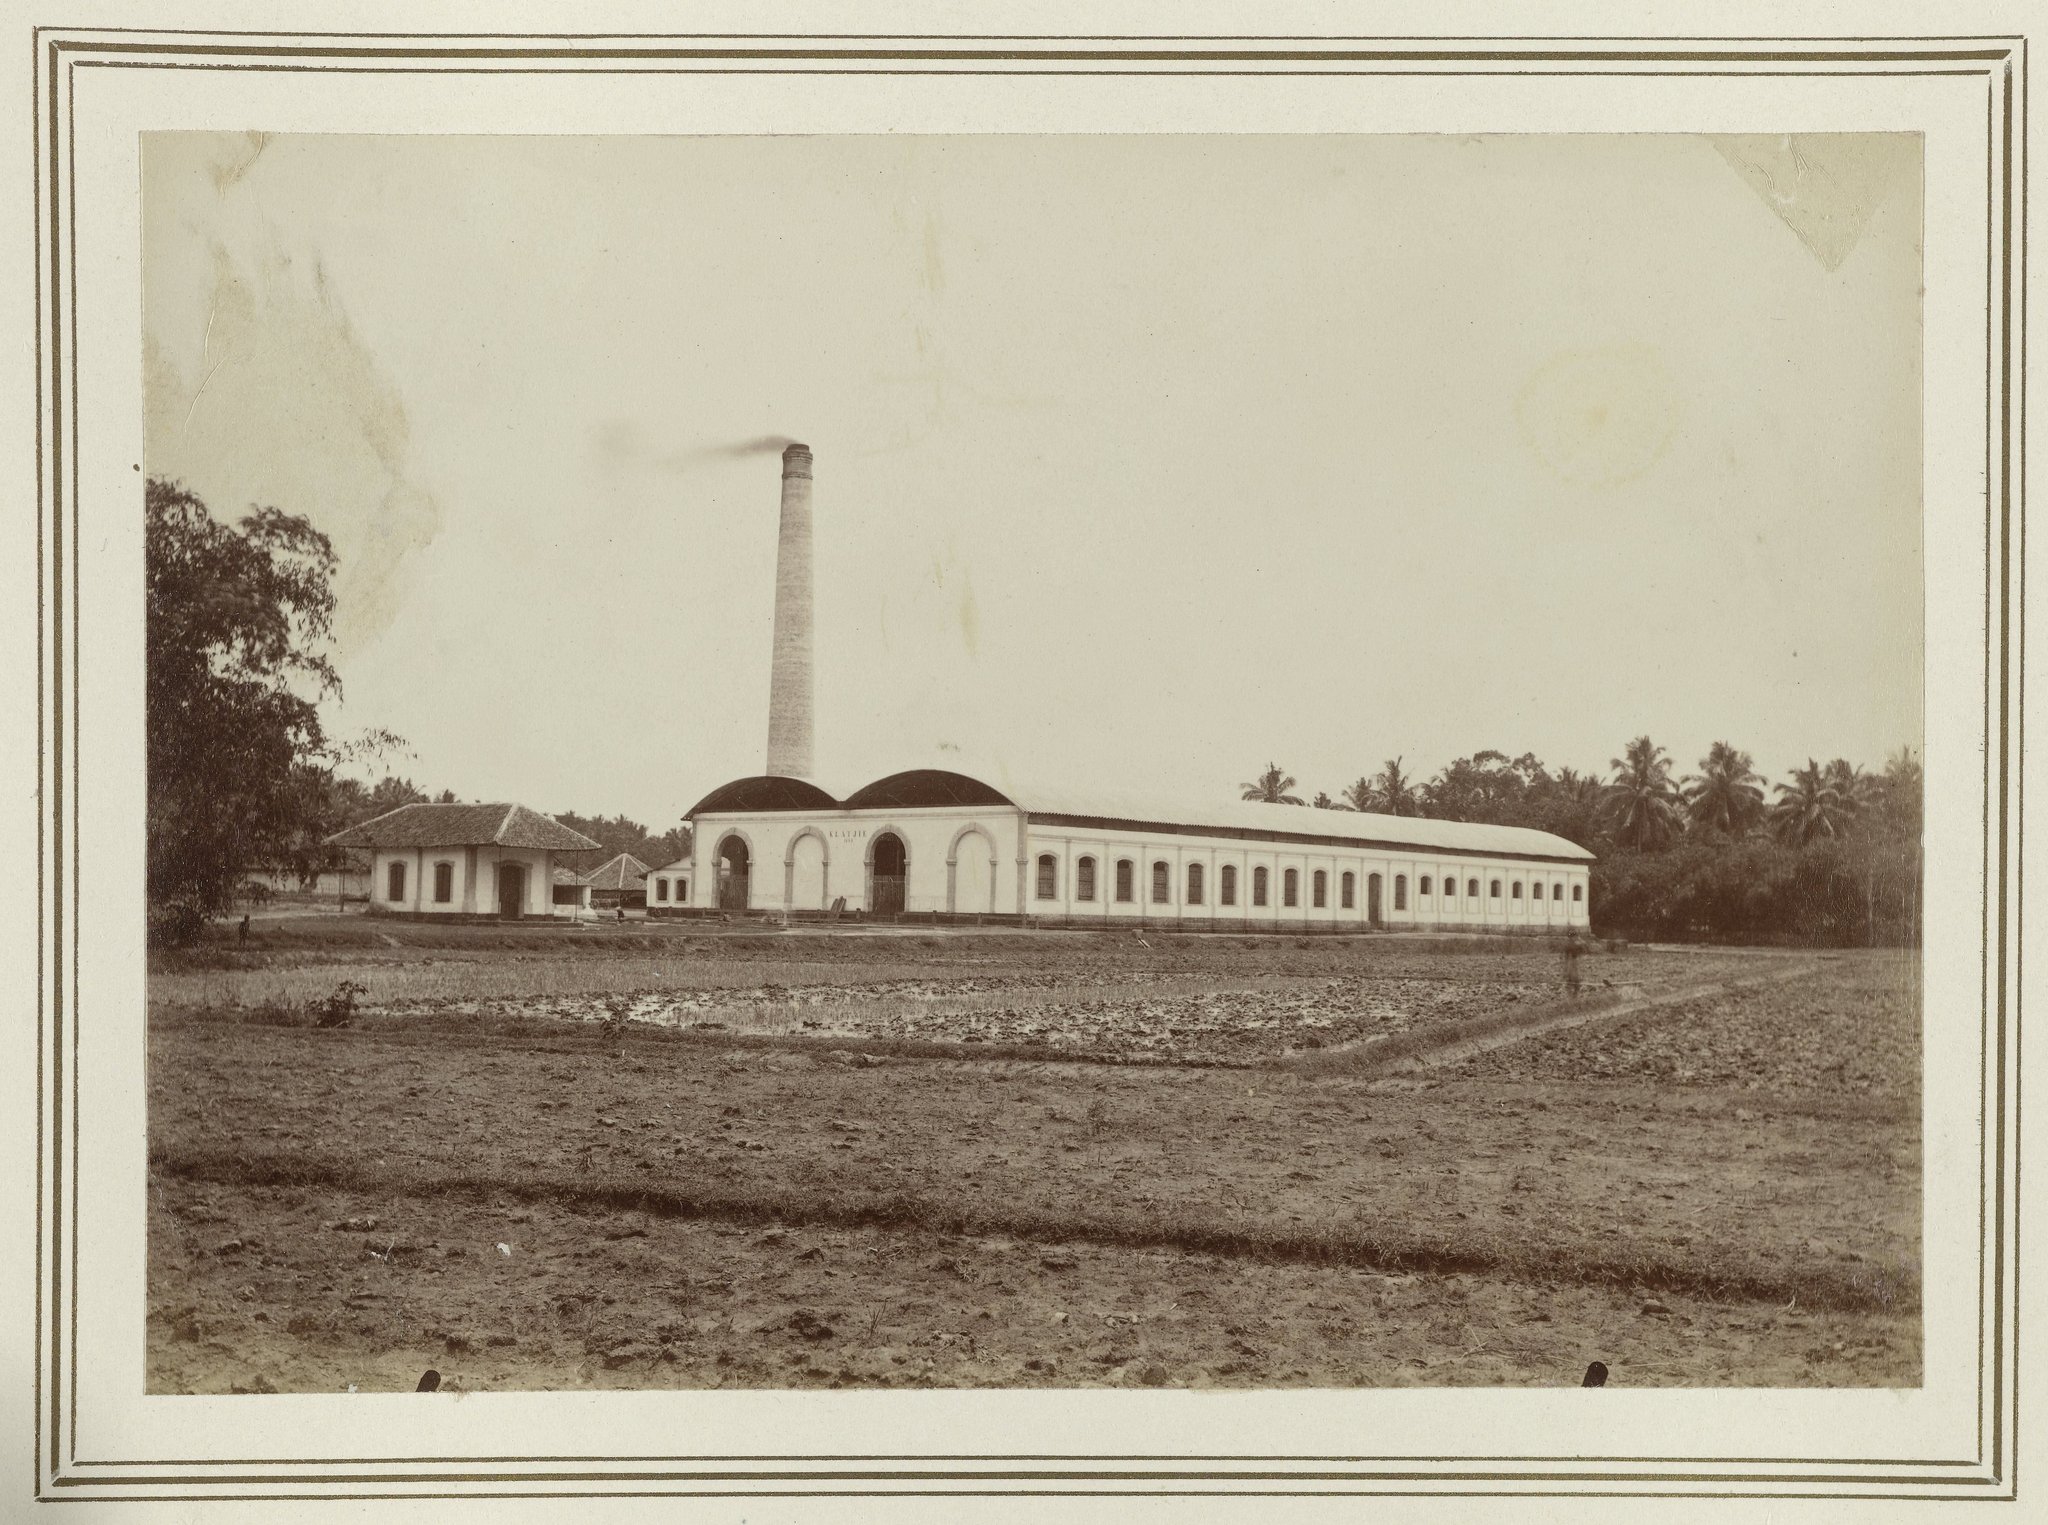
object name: photograph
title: Fabriek Klatjie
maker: kassian céphas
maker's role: fotograaf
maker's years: 1845-1912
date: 1886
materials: photographic support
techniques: albumen print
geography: jogjakarta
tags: the hague, colonial system, plantation, smoke-stack, factory-building, (non-fruit) products of plants or trees: sugarcane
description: Gezicht op de gebouwen van een fabriek genaamd Klatjie. Onderdeel van het fotoalbum aangeboden aan J.M. Pijnacker Hordijk bij zijn vertrek uit Jogyakarta in 1886.